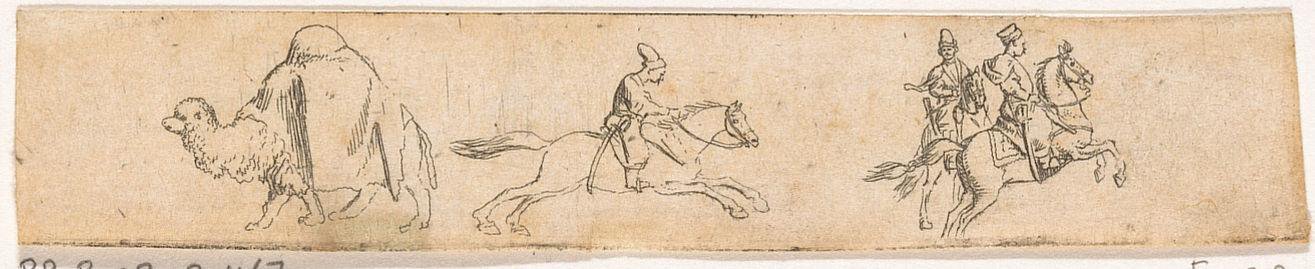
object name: print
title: Kameel en drie Poolse ruiters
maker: daniel nikolaus chodowiecki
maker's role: draughtsman, print maker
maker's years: 1726-1801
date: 1769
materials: paper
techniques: etching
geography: berlin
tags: riding a horse, ass, or mule; rider, horseman, hoofed animals: camel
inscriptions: collector's mark: Lugt 2228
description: Deze prent maakt deel uit van een serie van negen schetsen die Chodowiecki maakte in de randen van de koperplaat met illustraties voor de Duitse versie van Mina von Barnhelm (Engelmann 52). Later werden deze schetsen van de koperplaat losgesneden en apart gedrukt.